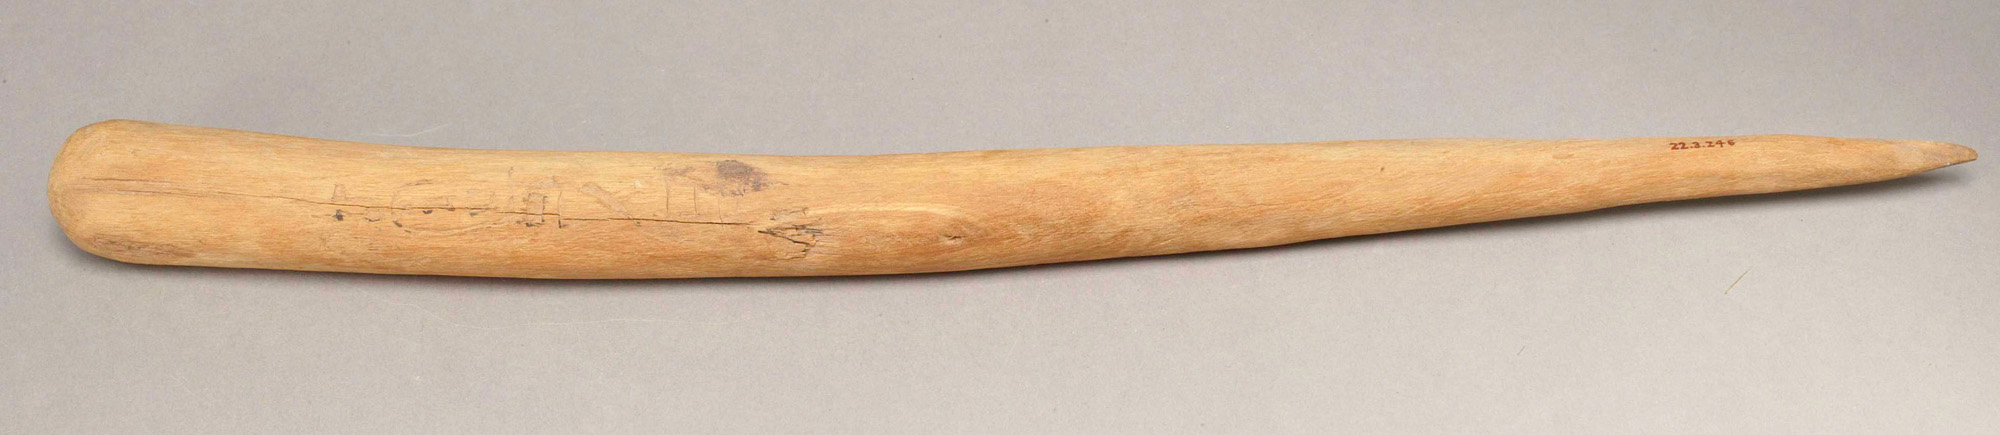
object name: stake, surveyor, hatshepsut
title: Surveyor's Stake from a Foundation Deposit for Hatshepsut's Temple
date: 1479-1458 BCE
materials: wood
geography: egypt